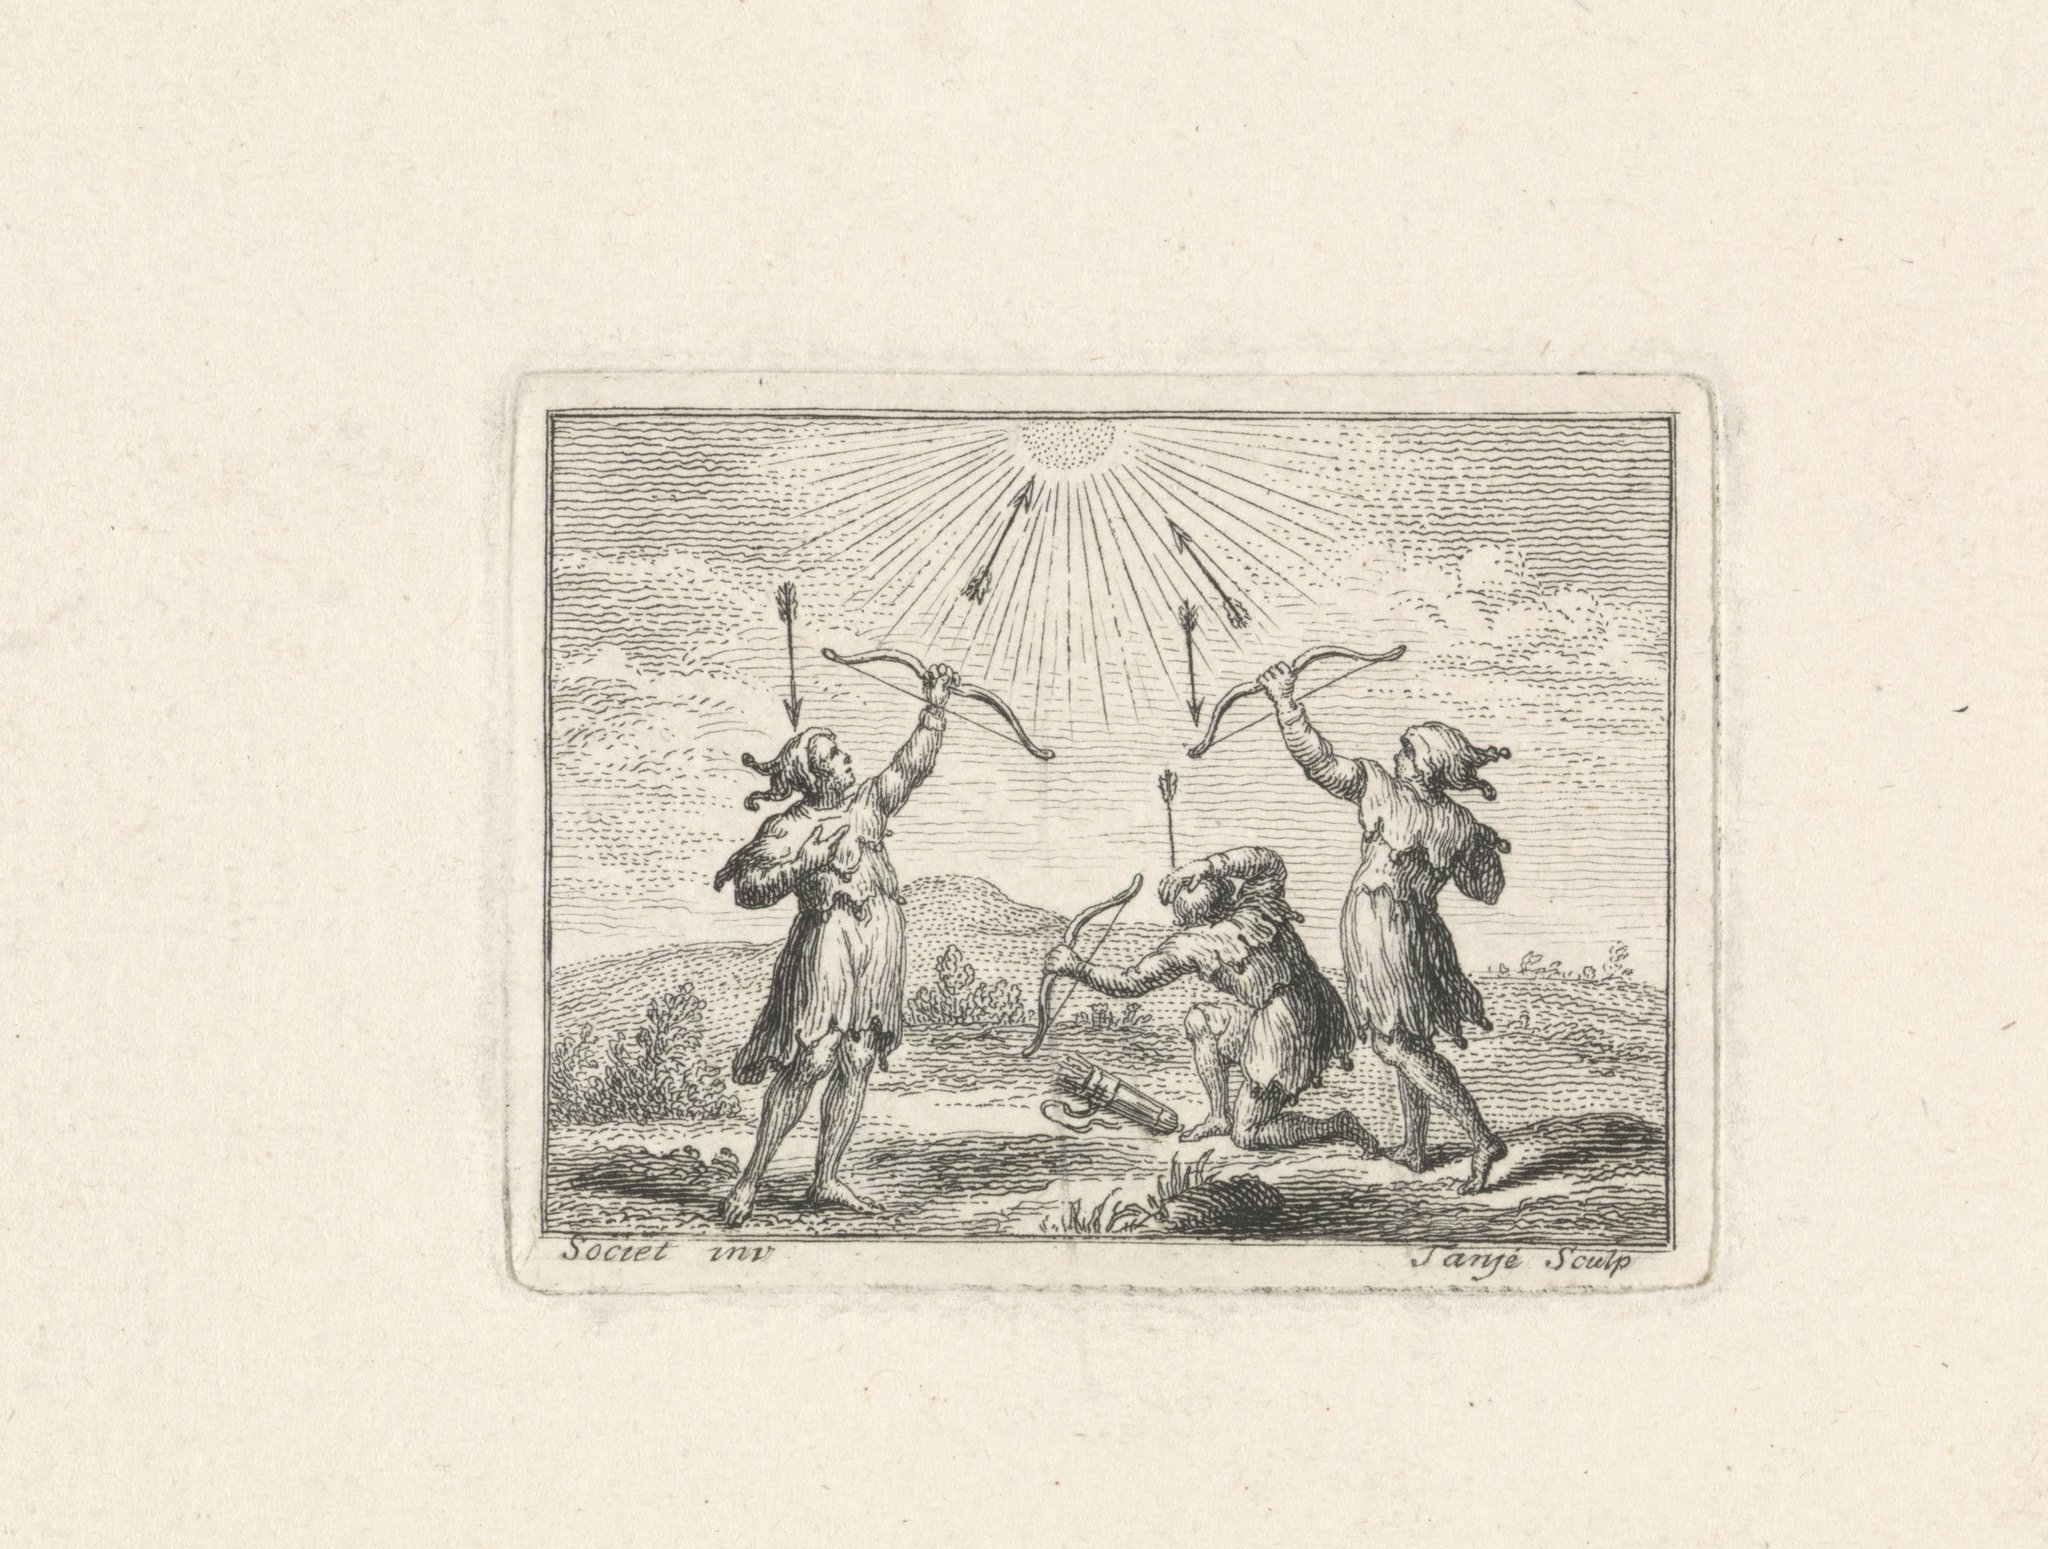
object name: print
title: Twee boogschutters schieten op de zon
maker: pieter tanjé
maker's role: draughtsman, print maker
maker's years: 1706-1761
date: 1716-1761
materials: paper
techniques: engraving, etching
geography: amsterdam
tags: archer's weapons: bow, sun as celestial body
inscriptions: collector's mark: Lugt 240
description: Twee boogschutters schieten op de zon, een derde krijgt de pijlen op zijn hoofd.